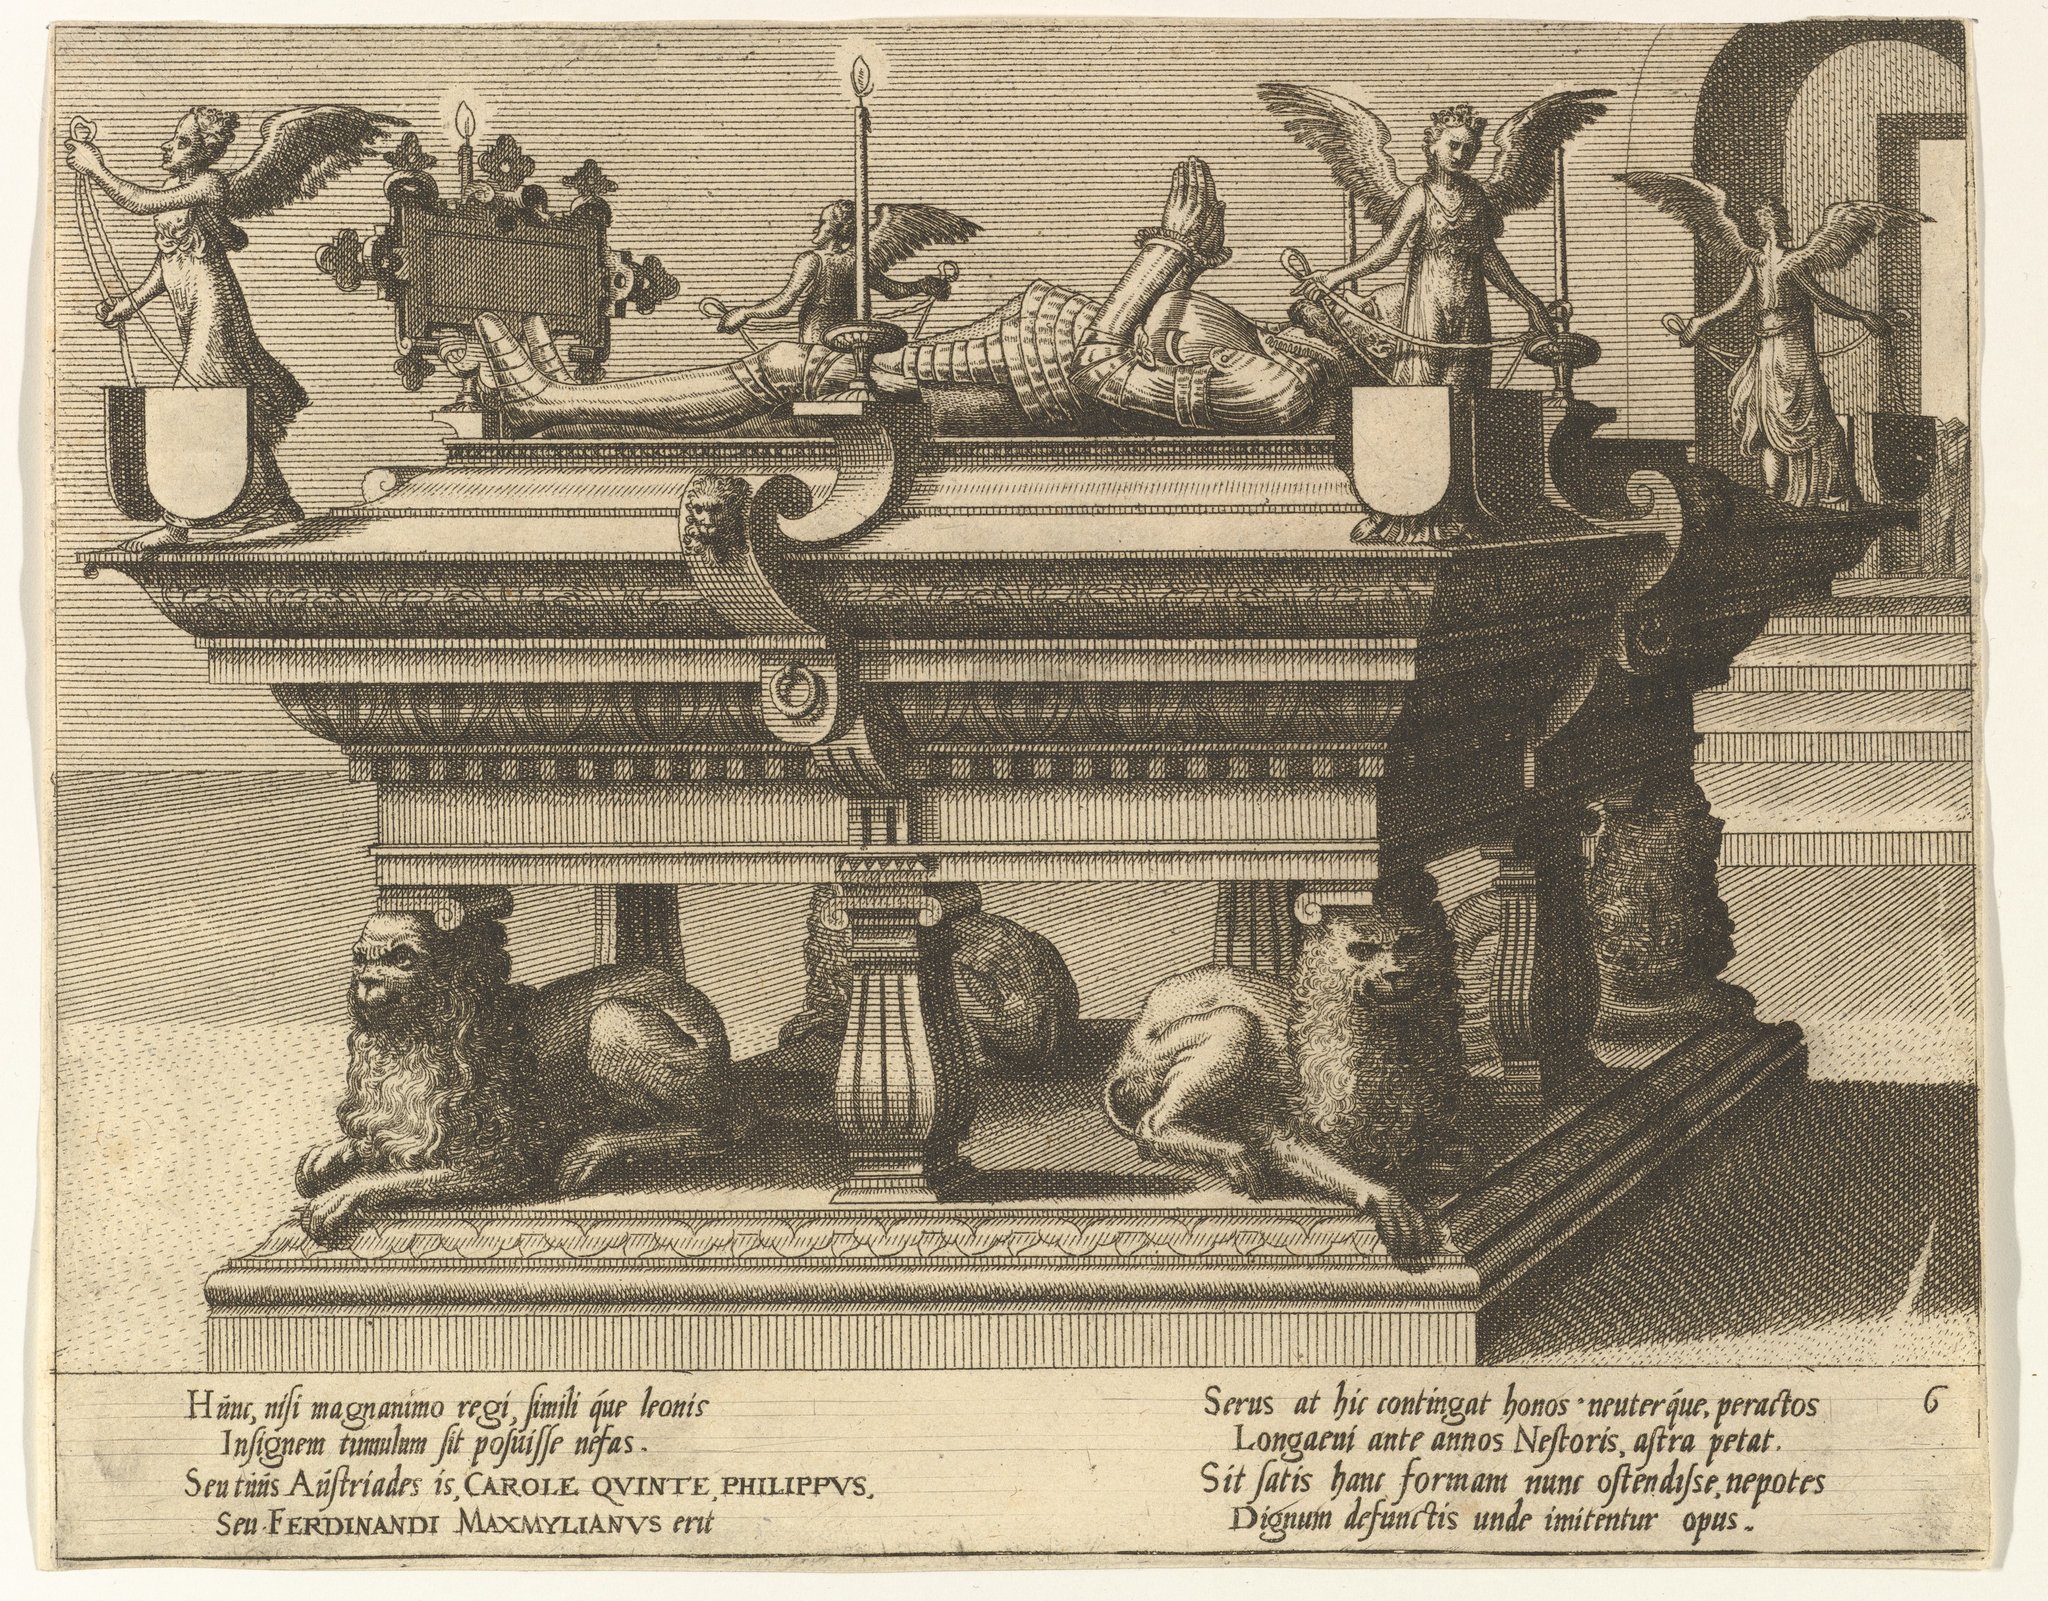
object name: collection ornament architecture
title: Cœnotaphiorum (6)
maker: hans vredeman de vries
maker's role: artist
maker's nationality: netherlandish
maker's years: 1527-1606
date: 1563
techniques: etching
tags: monuments,armor,lions,angels,coat of arms